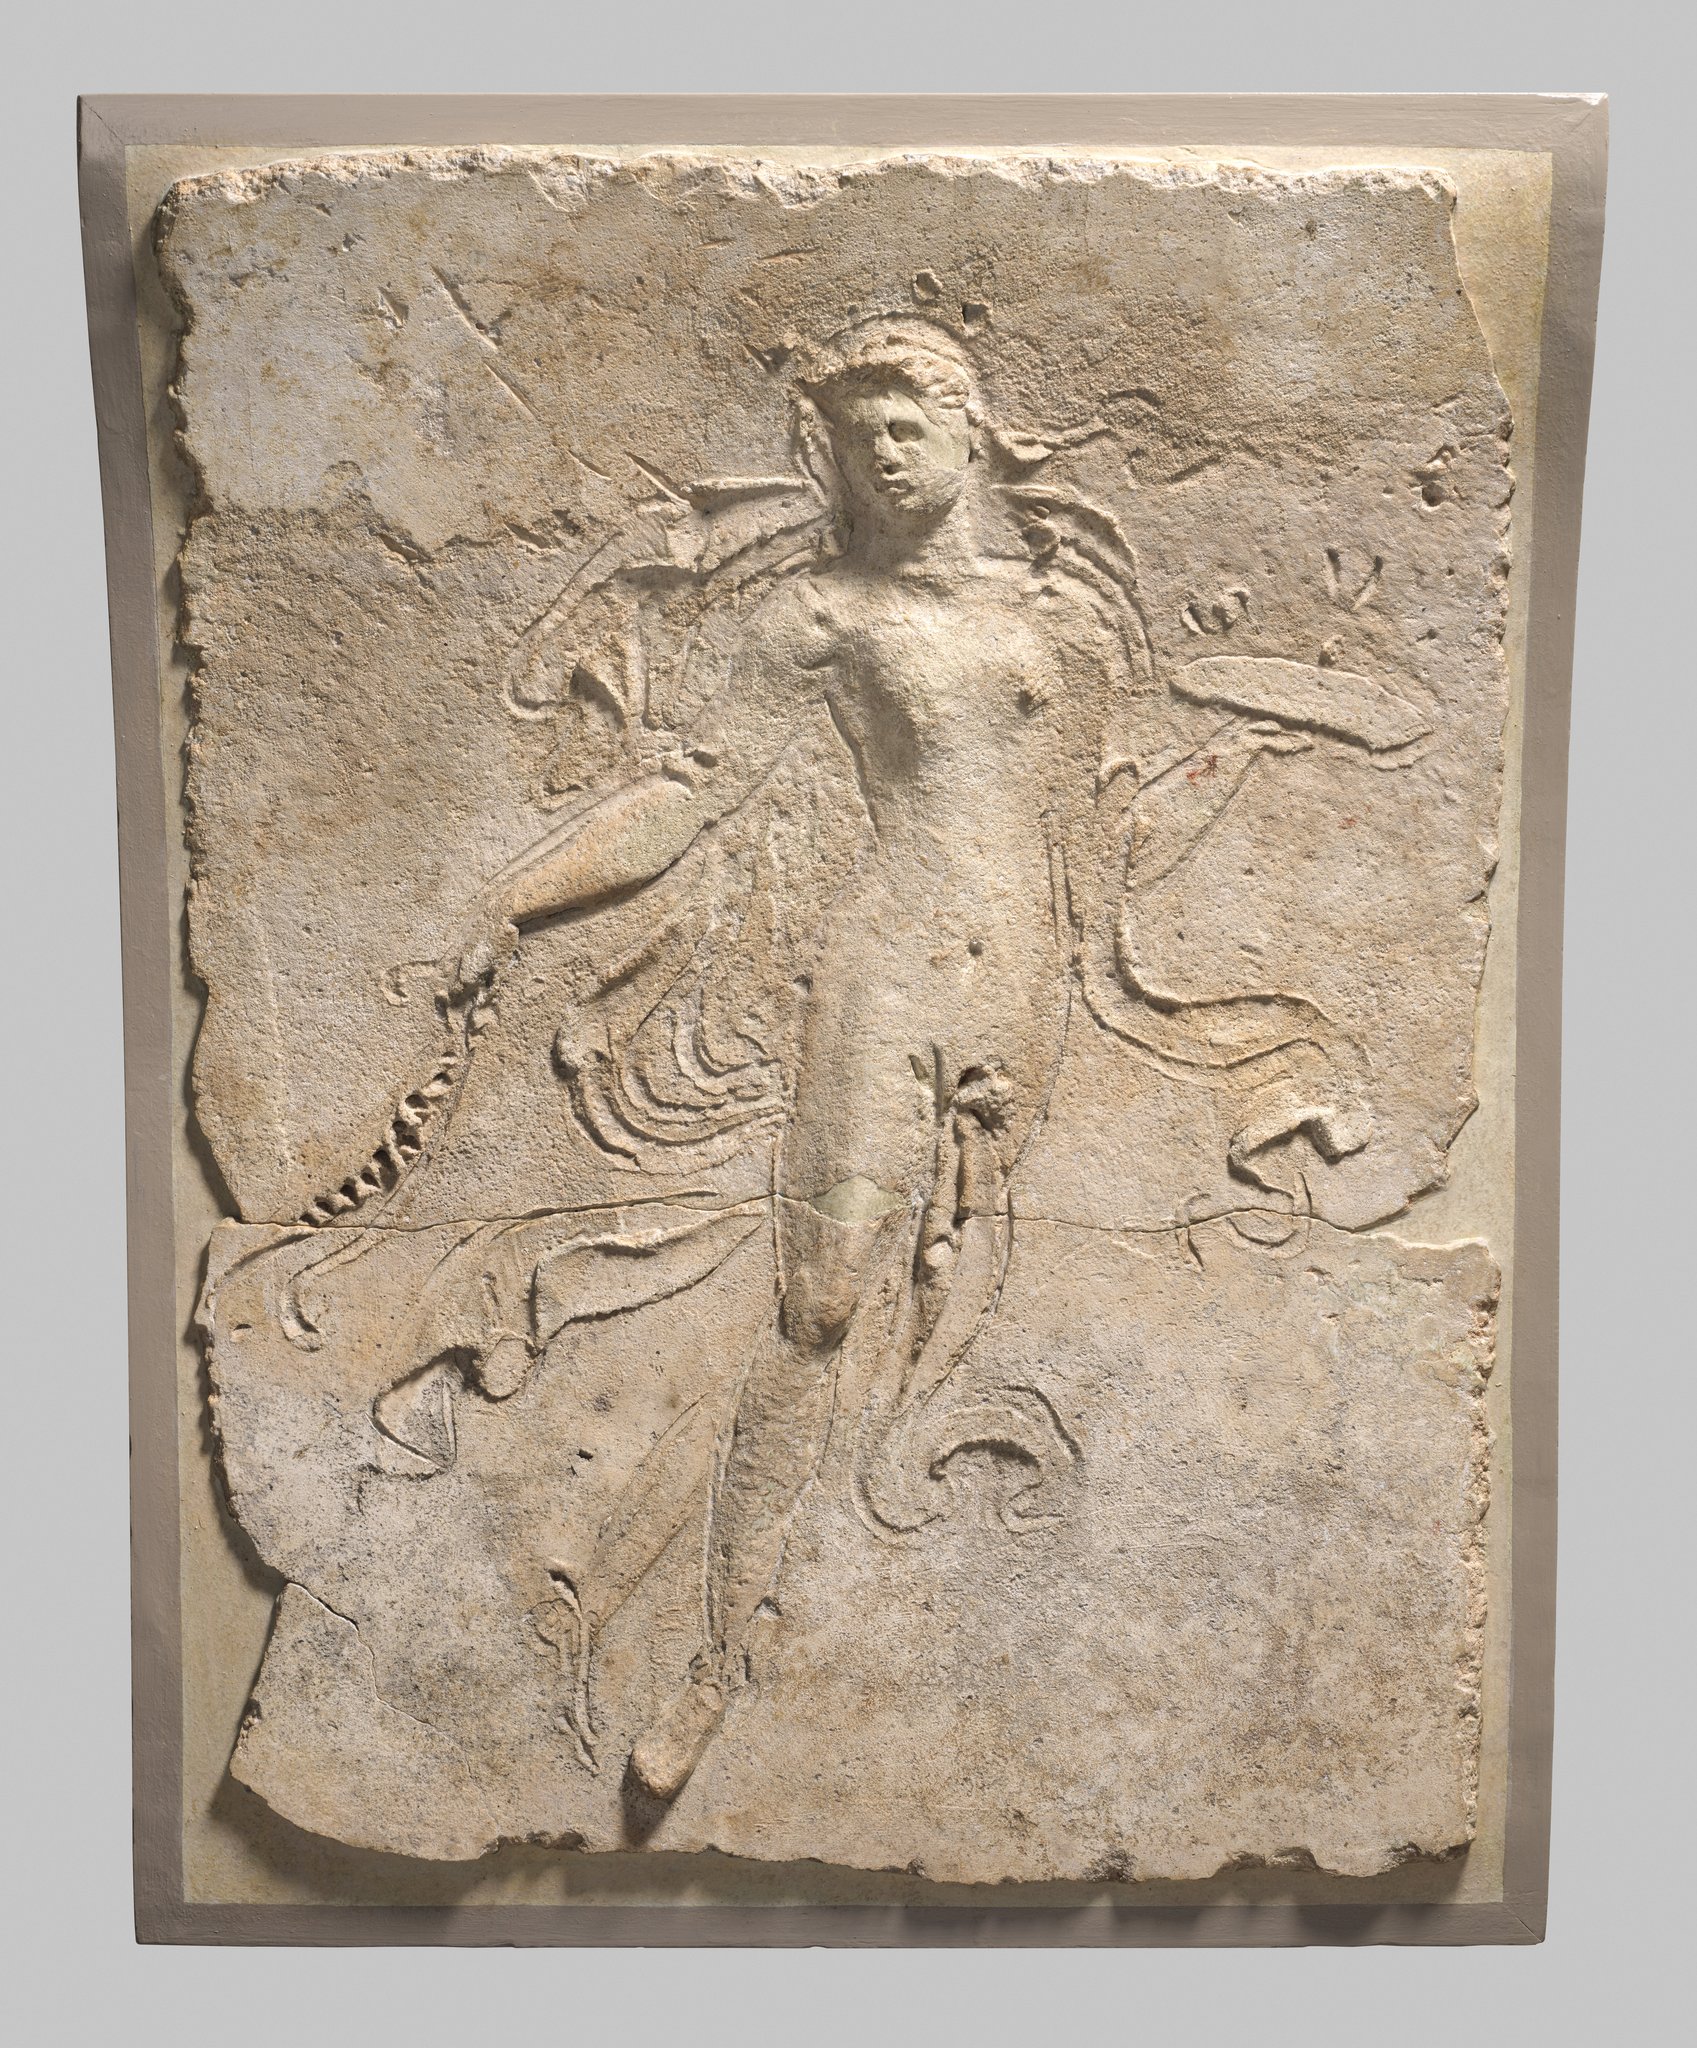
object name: stucco relief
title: Stucco relief panel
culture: roman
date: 51-100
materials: plaster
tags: female nudes